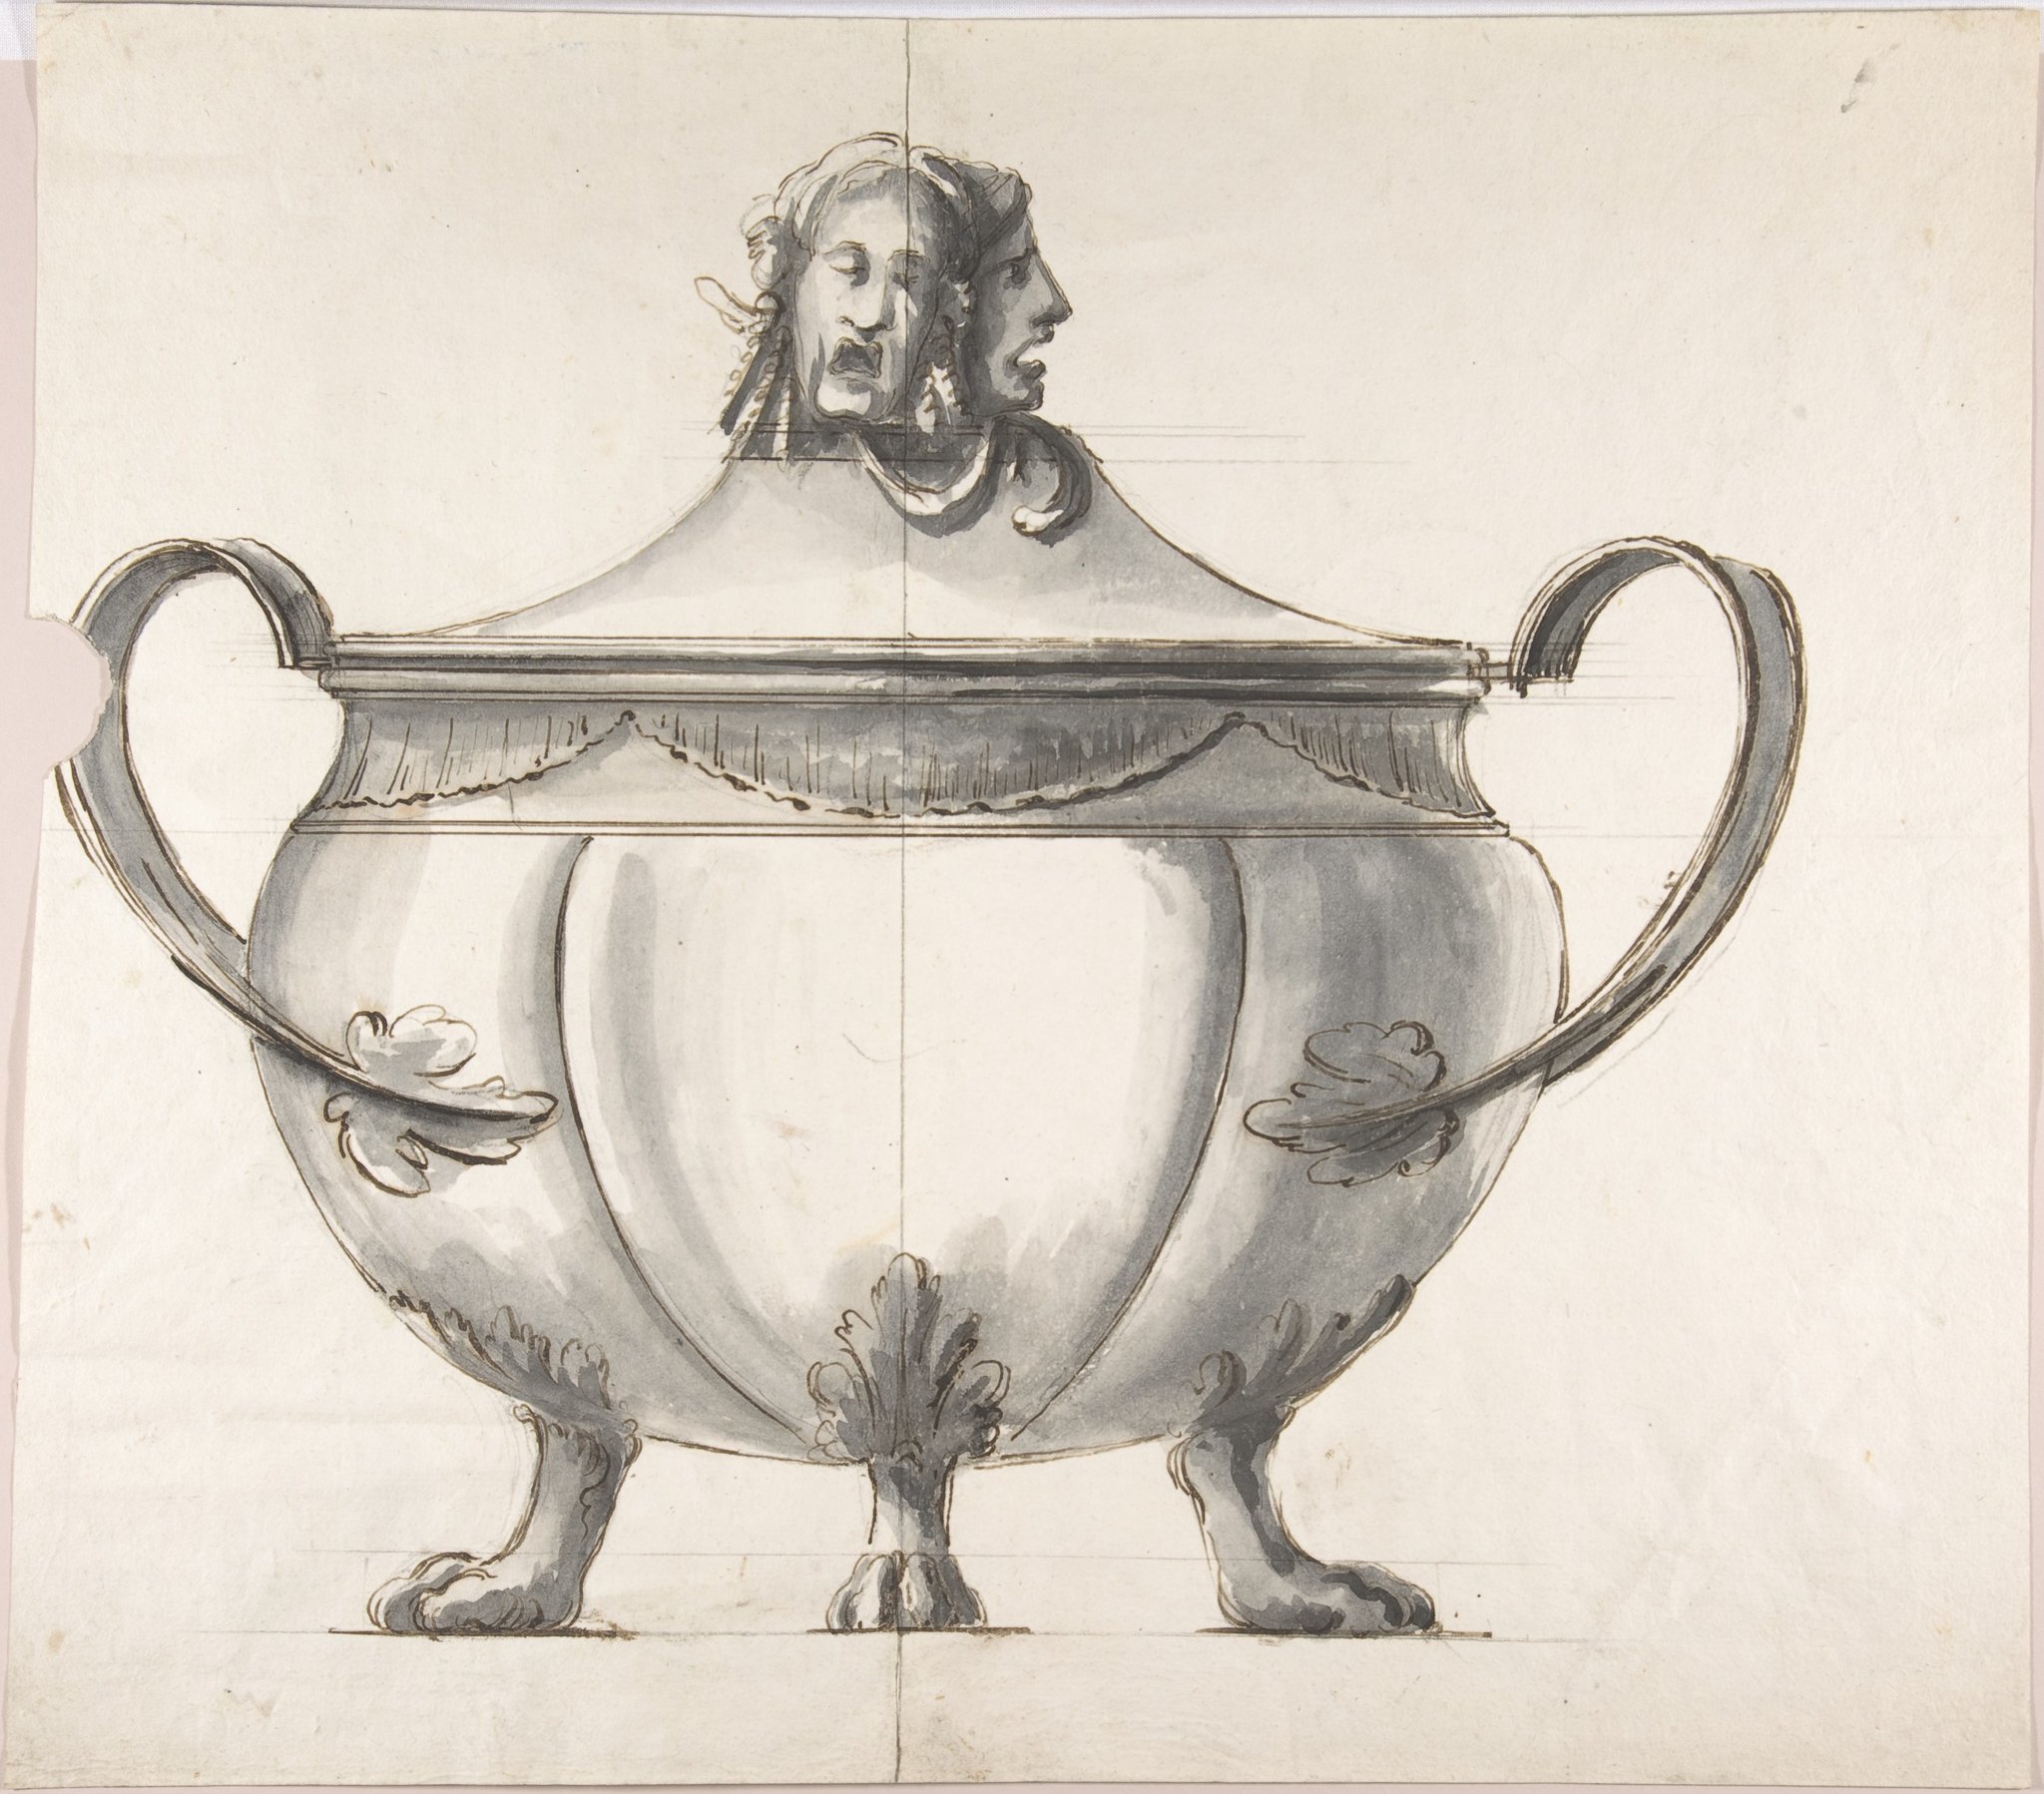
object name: drawing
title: Tureen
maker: anonymous, italian, 19th century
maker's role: artist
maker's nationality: italian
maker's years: 1800-1900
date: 1801-1900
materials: ink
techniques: pen, wash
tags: tureens